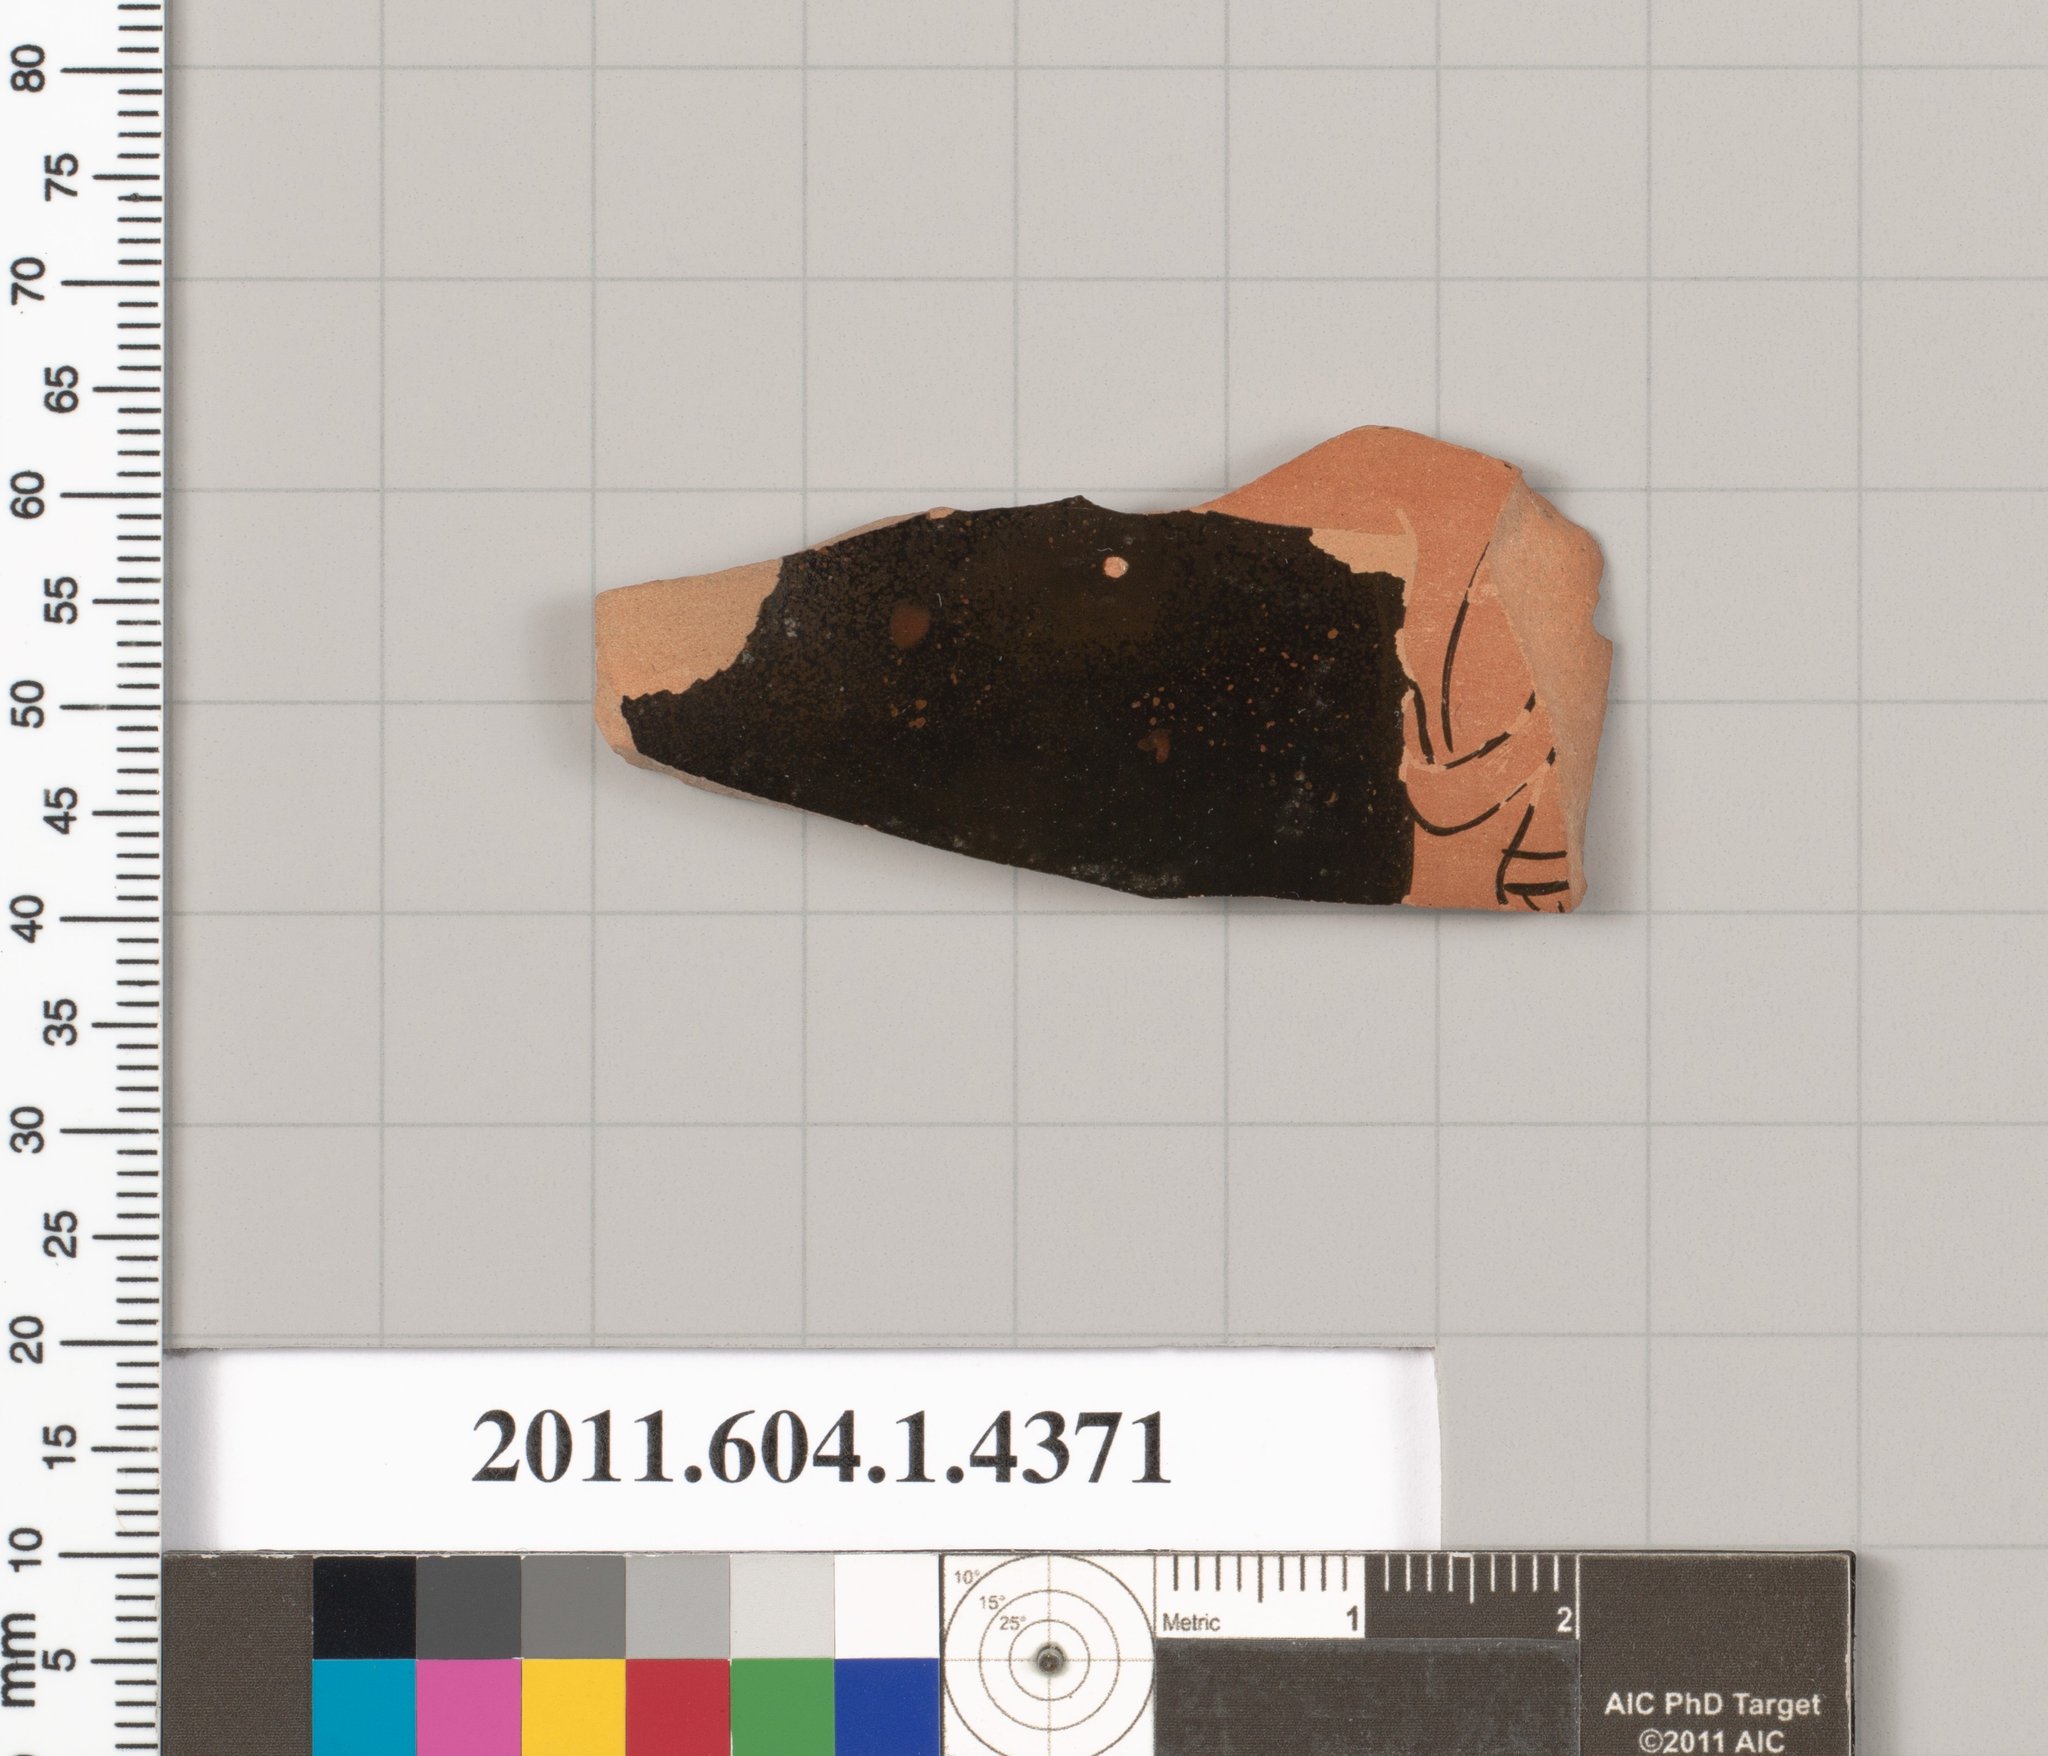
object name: kylix fragment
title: Terracotta fragment of a kylix (drinking cup)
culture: greek, attic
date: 475-451 BCE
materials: terracotta